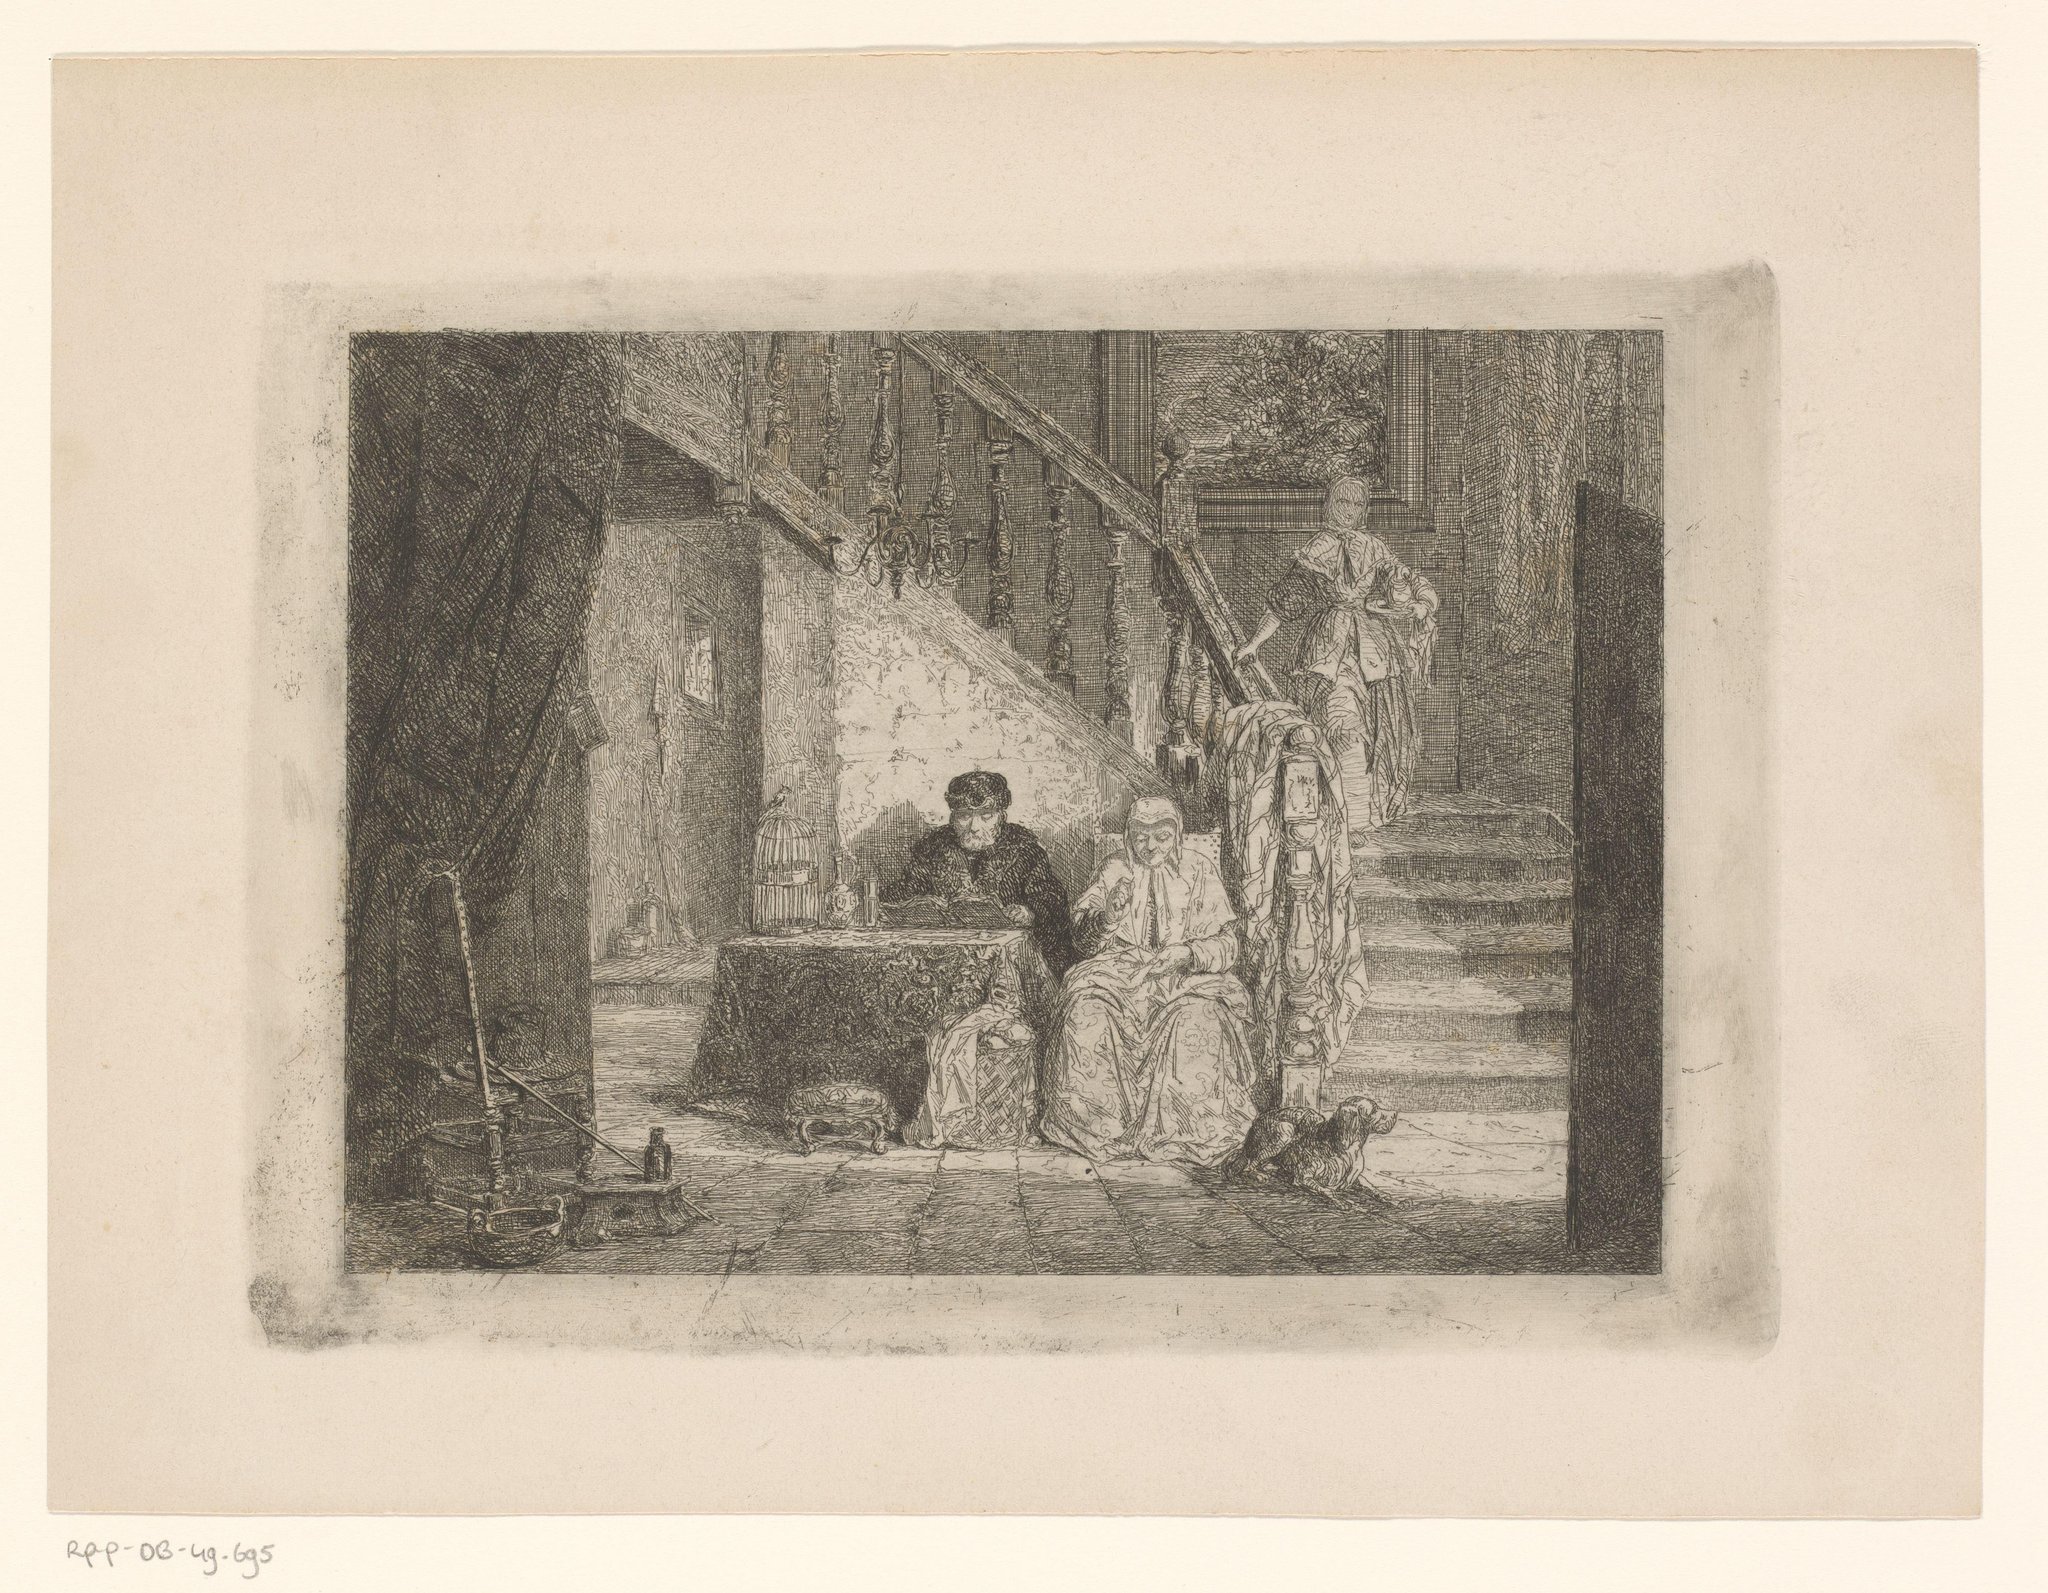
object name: print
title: Jonge vrouw loopt van een trap waarnaast een oude man en vrouw zitten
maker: guillaume joseph vertommen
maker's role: print maker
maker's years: 1815-1863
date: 1850-1863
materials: paper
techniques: etching, intaglio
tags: care and laundering of clothes; home sewing, reading, interior of the house, staircase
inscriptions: collector's mark: Lugt 2228, inscription: ‘Revue de Belgique/ 5 Annee, 2 serie, Tome VI/ Alfred Stevens Pinx./ W.Vertommen Aq.Forti/ Fête Artistique 5 janvier 1850’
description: Latere staat verschenen in: l'Album de la Fête artistique à Bruxelles, 1850, pl. 18.